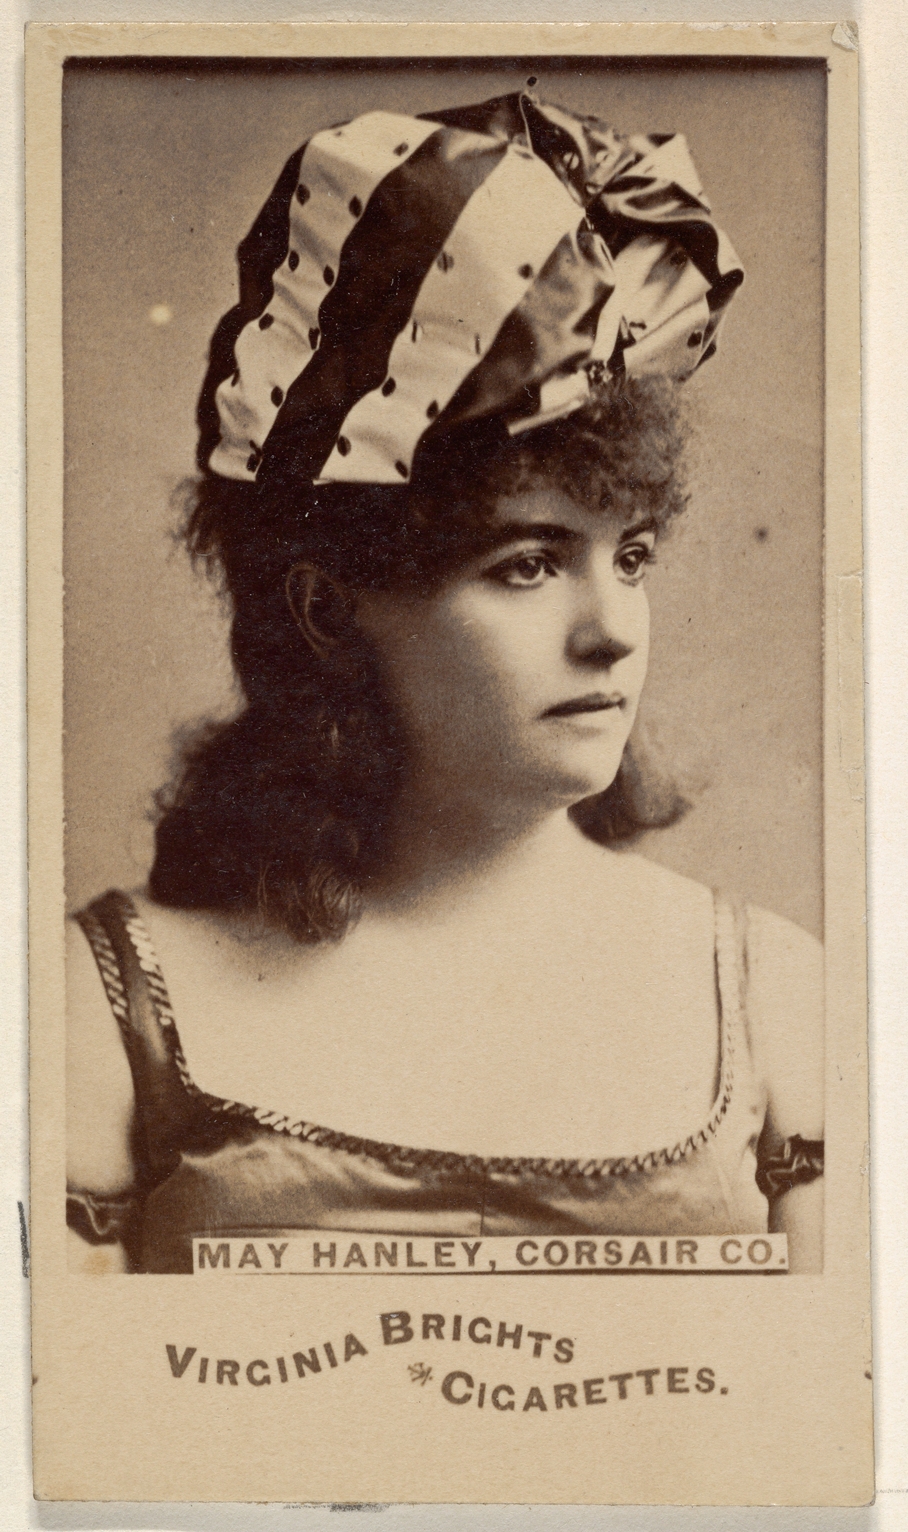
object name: photograph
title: May Hanley, Corsair Co., from the Actors and Actresses series (N45, Type 6) for Virginia Brights Cigarettes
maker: allen & ginter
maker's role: publisher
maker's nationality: american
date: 1888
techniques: albumen silver print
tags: portraits,women,actresses